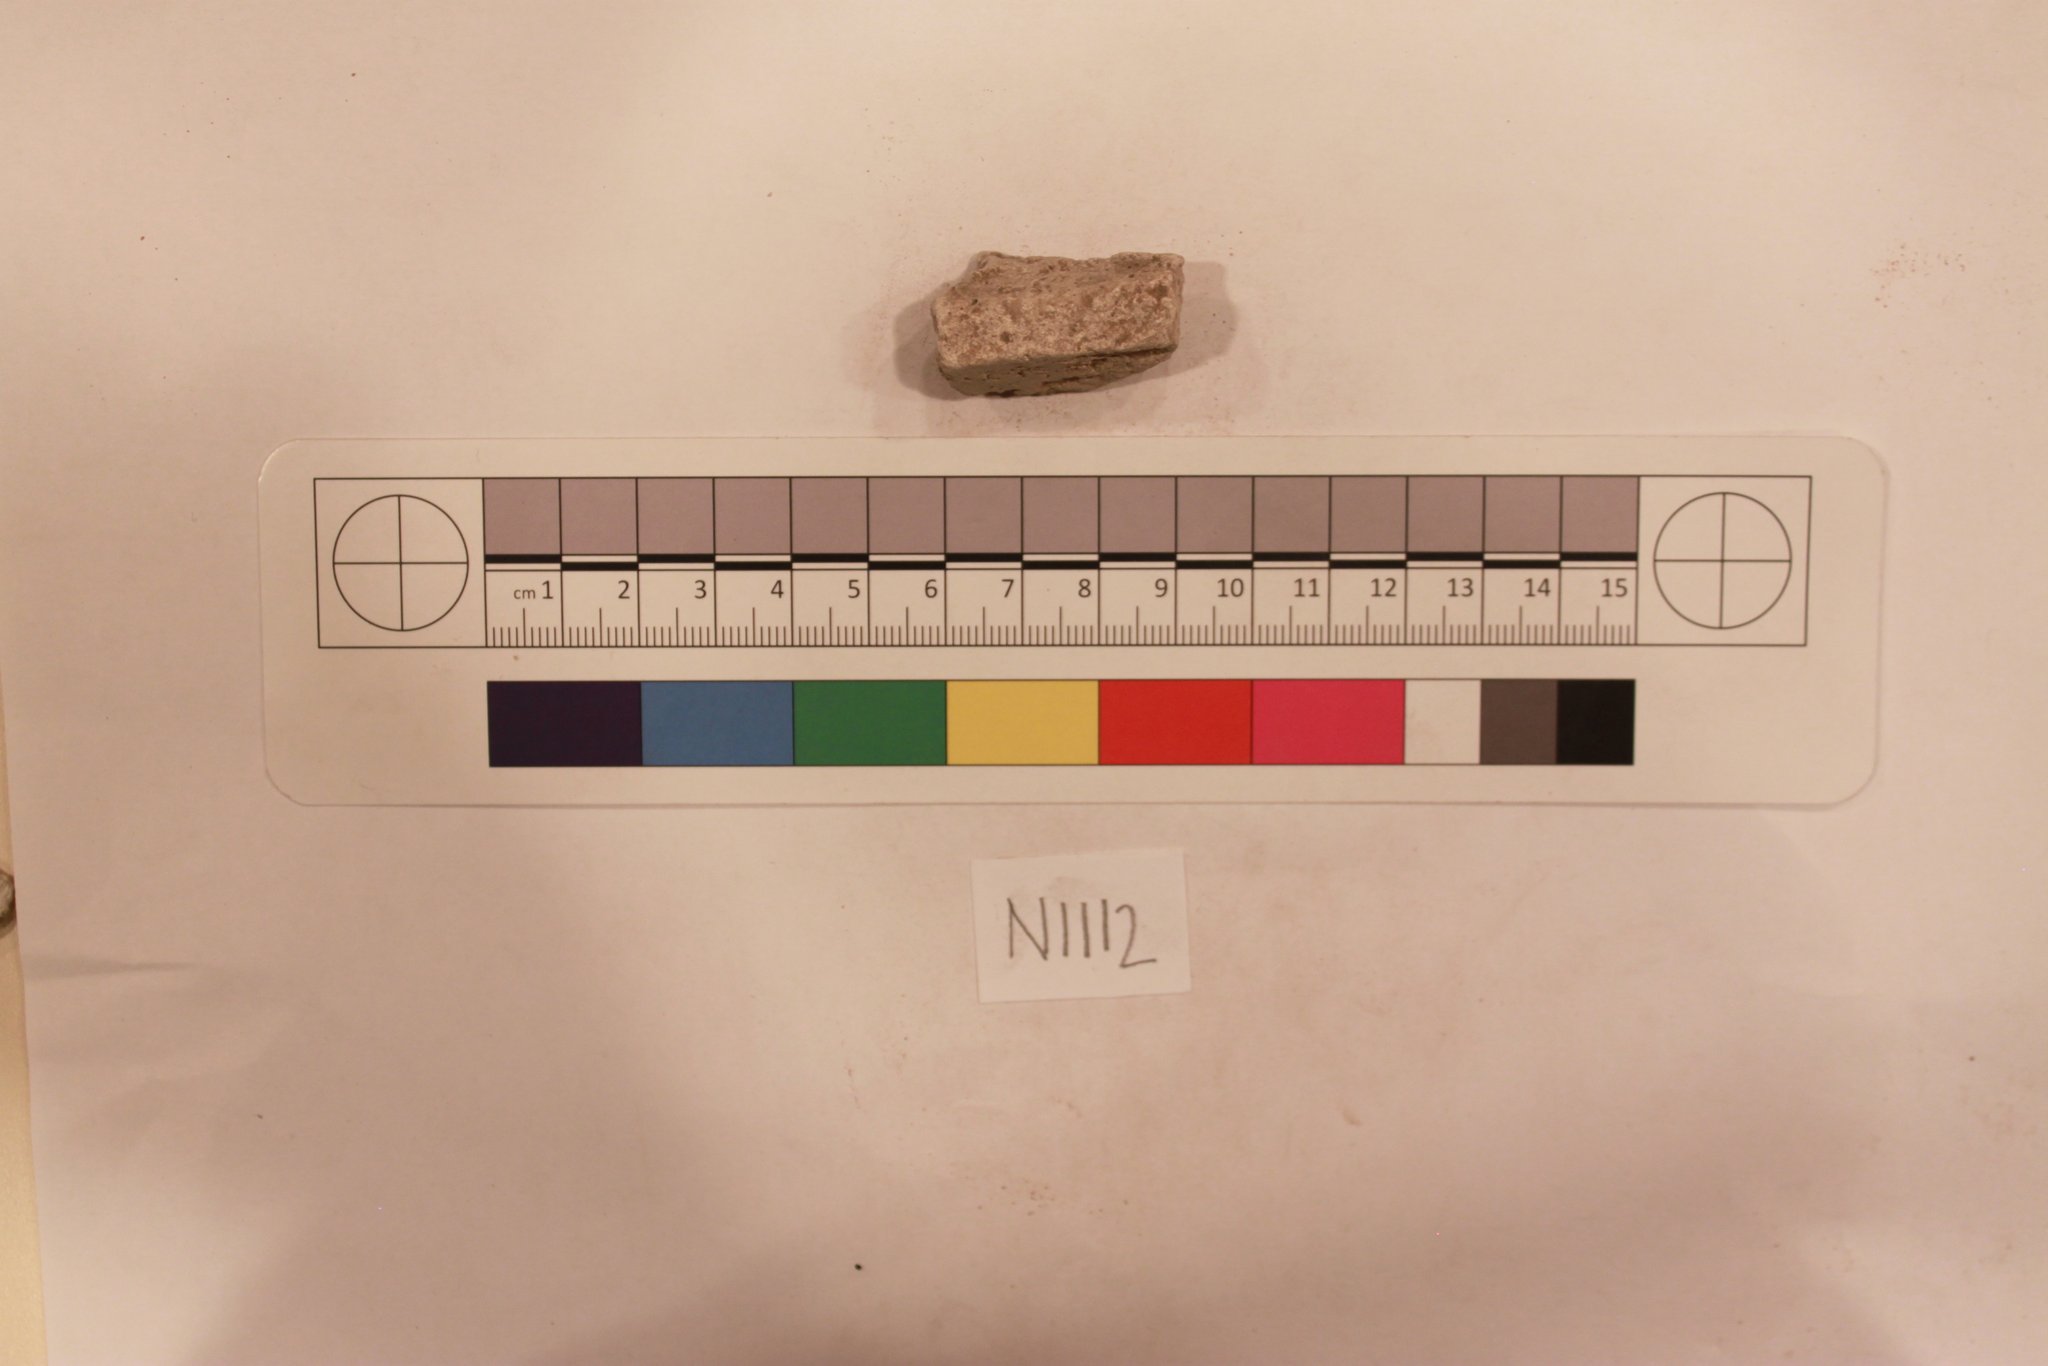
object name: fragment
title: Stucco Fragment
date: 701-1200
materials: plaster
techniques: carving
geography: iran